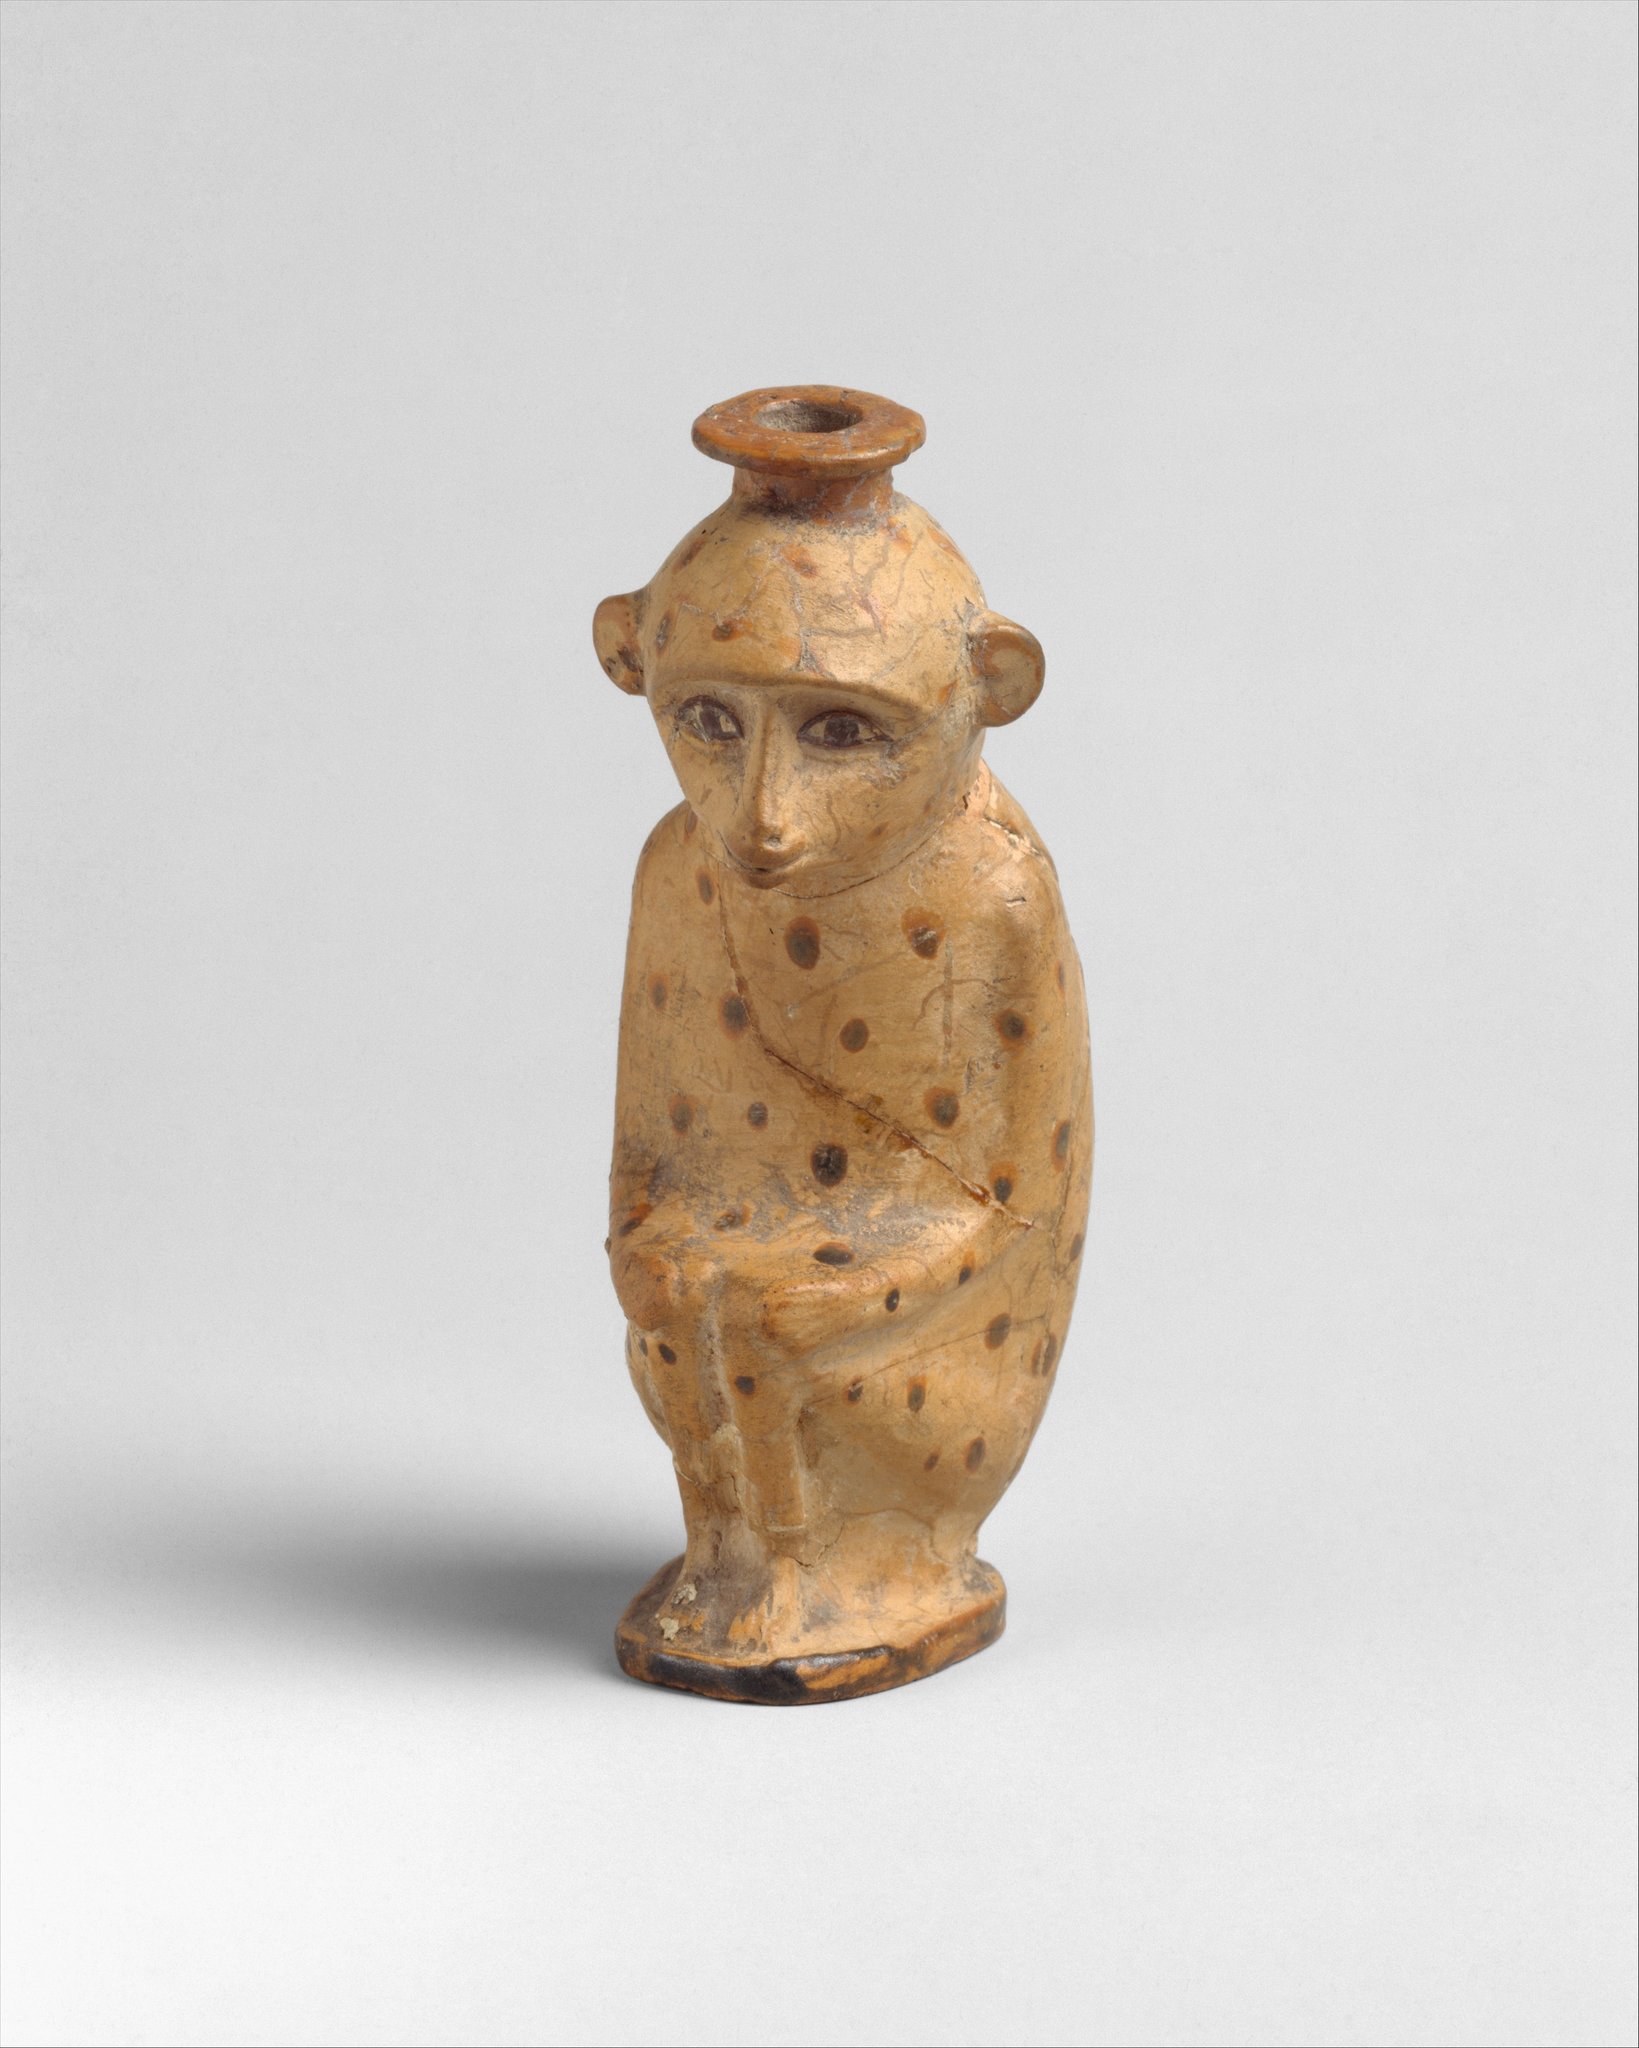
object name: vase, monkey, baby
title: Terracotta aryballos (perfume vase) in the form of a monkey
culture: rhodian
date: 600-576 BCE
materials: terracotta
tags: monkeys